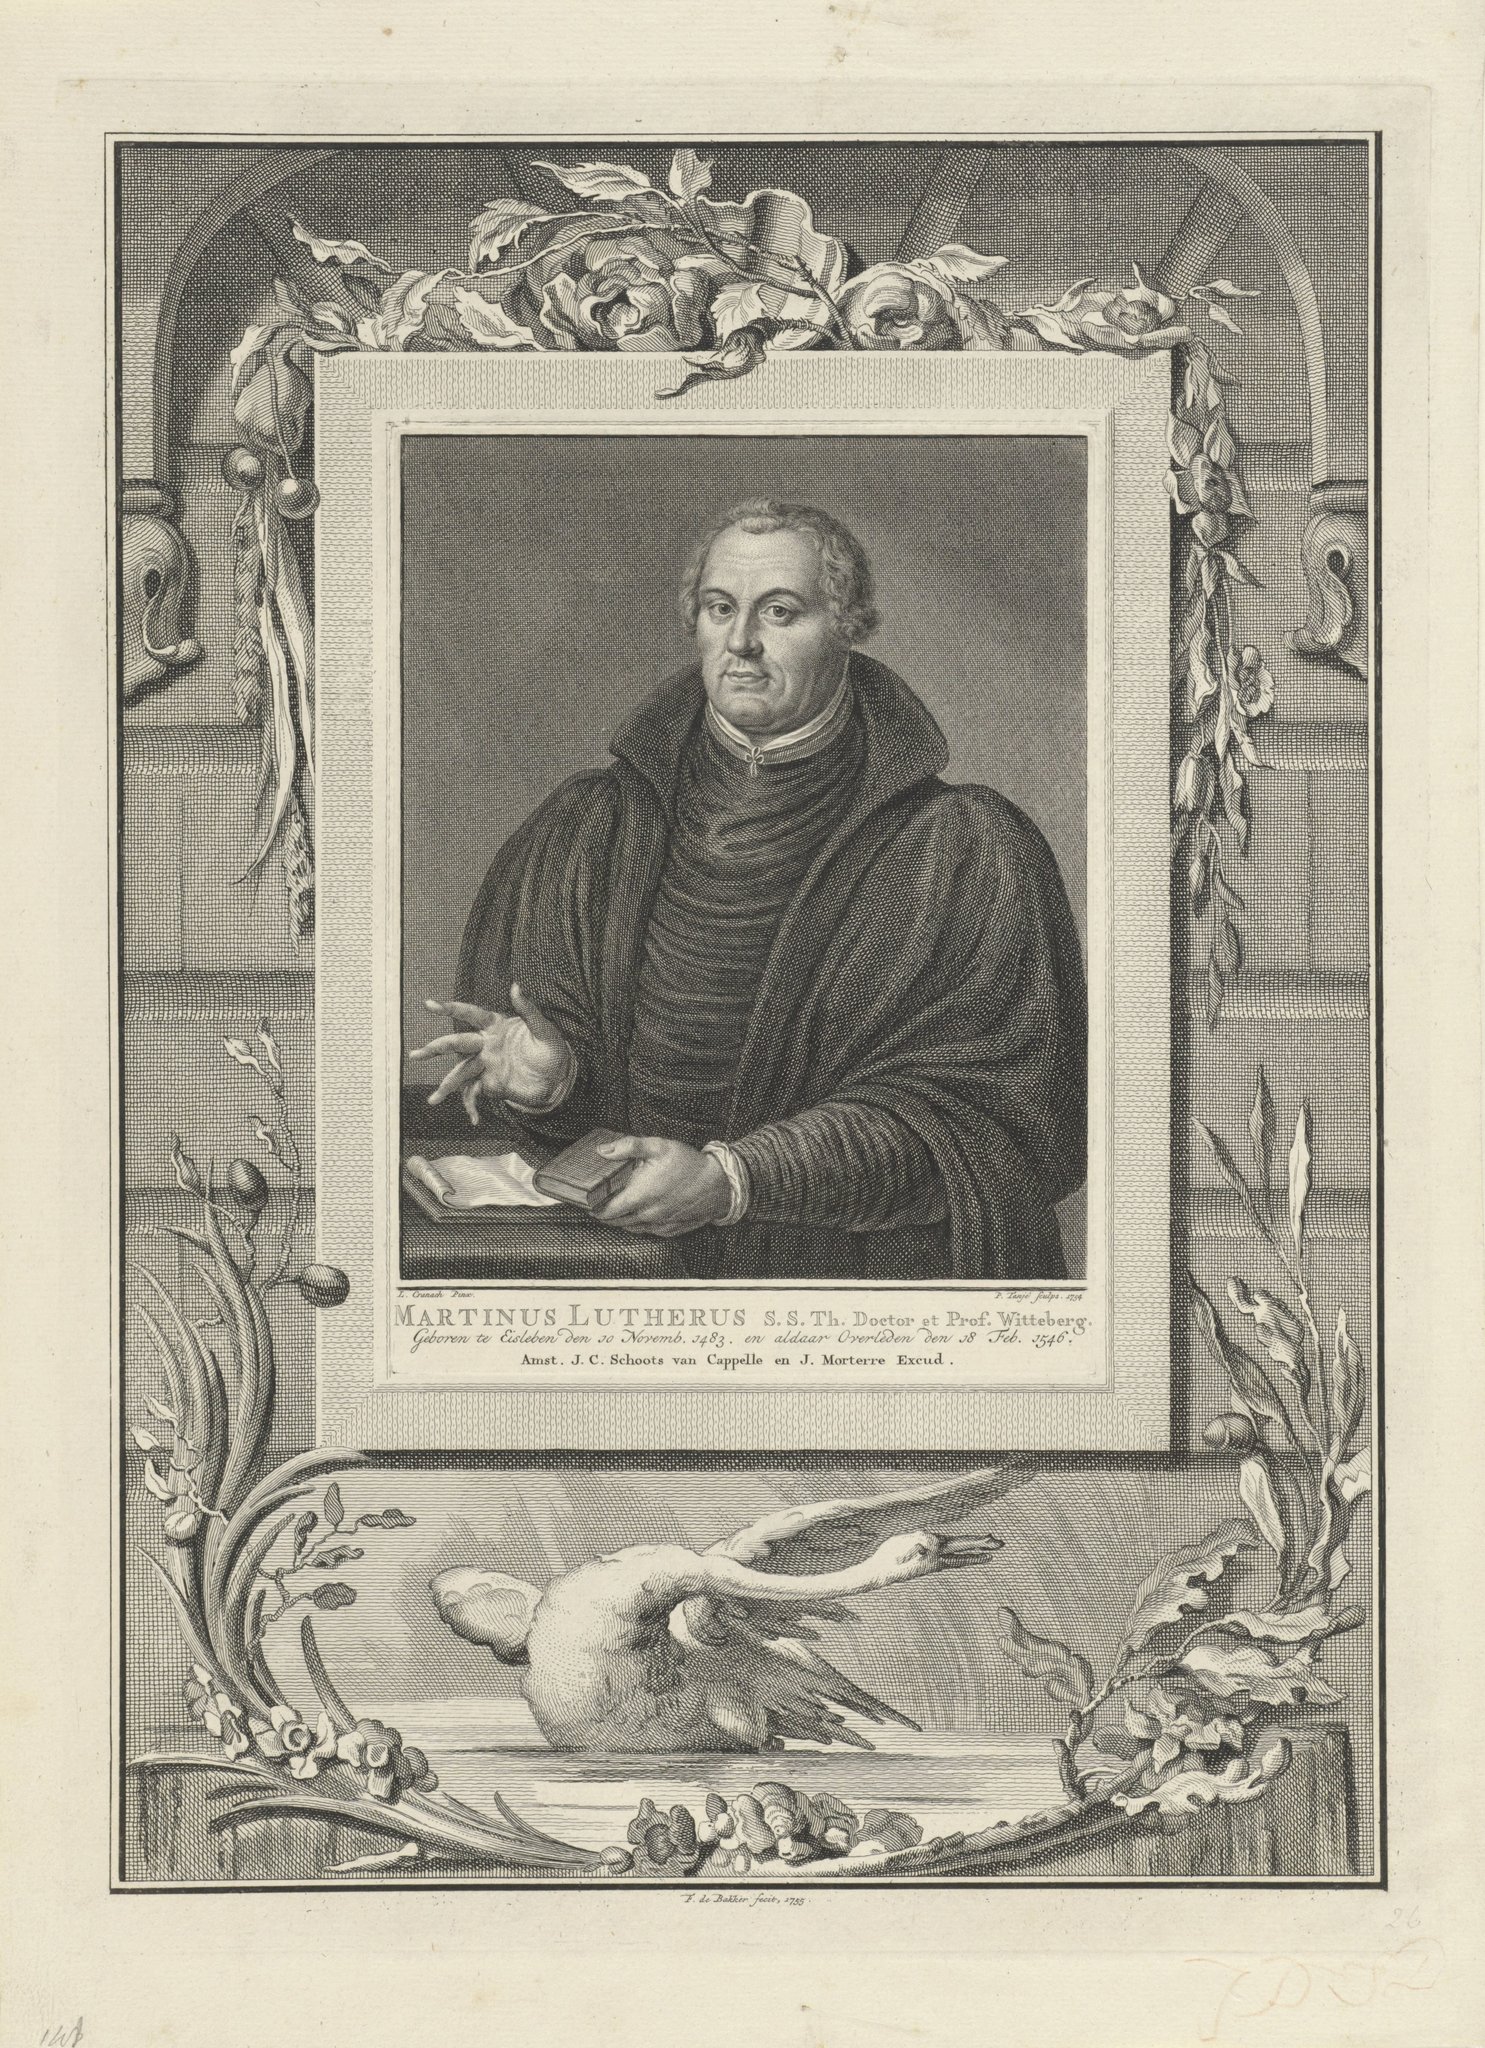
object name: print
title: Portret van Maarten Luther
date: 1754-1755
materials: paper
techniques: engraving, etching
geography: amsterdam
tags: priest, martin luther, water-birds: swan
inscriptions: collector's mark: Lugt 240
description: Portret van Maarten Luther, staand bij een tafel, met een Bijbel in zijn hand. Rond het portret guirlandes van bloemen en planten. Onderaan de zwaan als symbool van Luther.